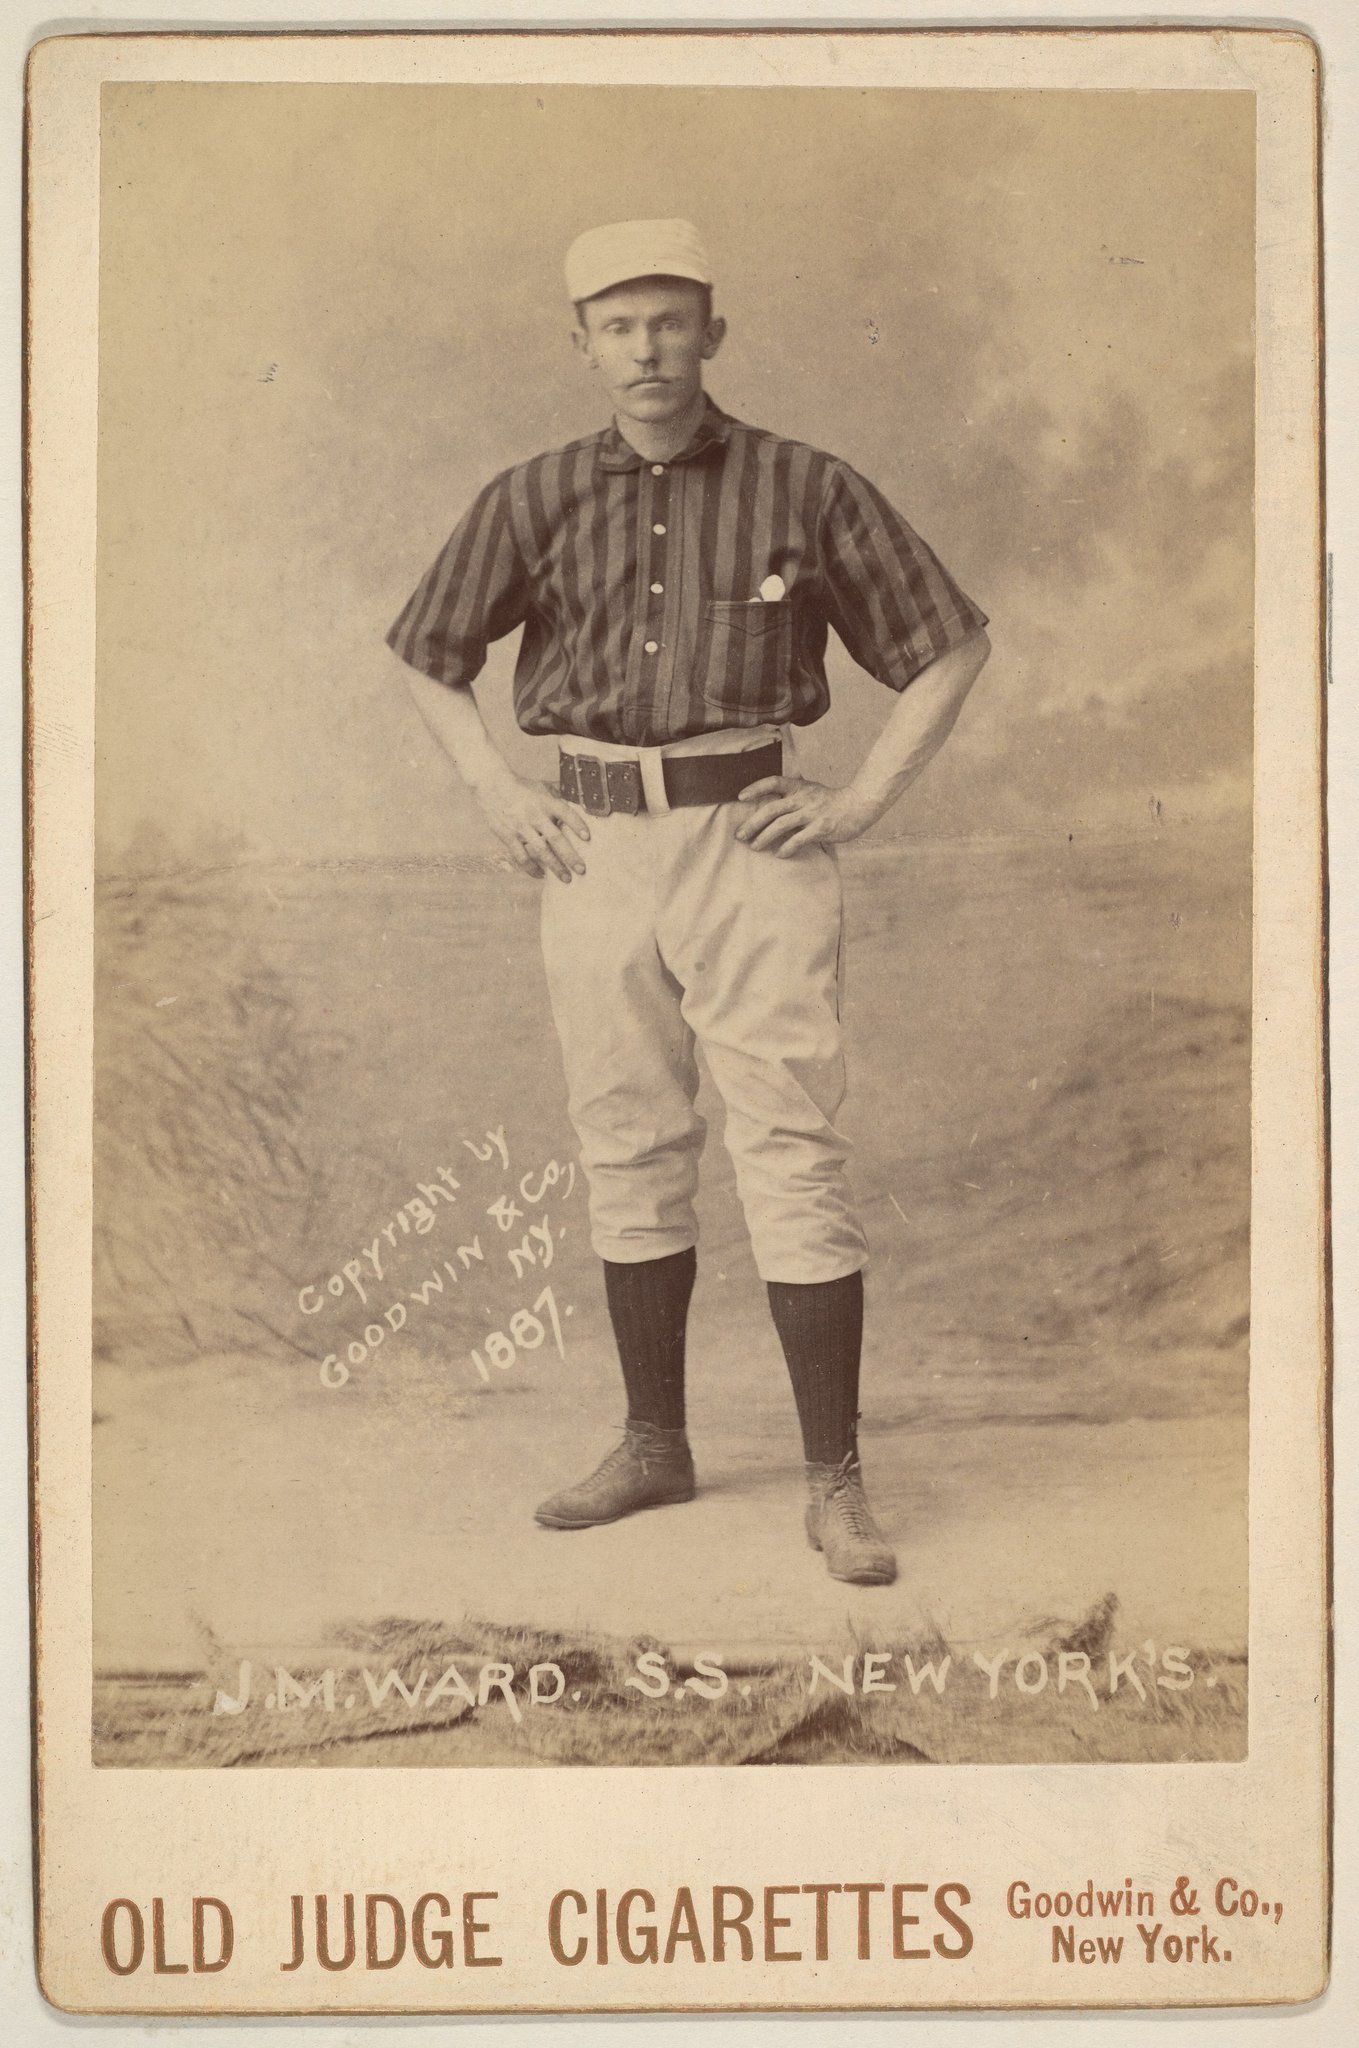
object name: baseball card, photograph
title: J.M. Ward, Shortstop, New York, from the series Old Judge Cigarettes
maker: goodwin & company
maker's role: publisher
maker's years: 1850-1950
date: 1887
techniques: albumen silver print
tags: men,portraits,baseball,athletes